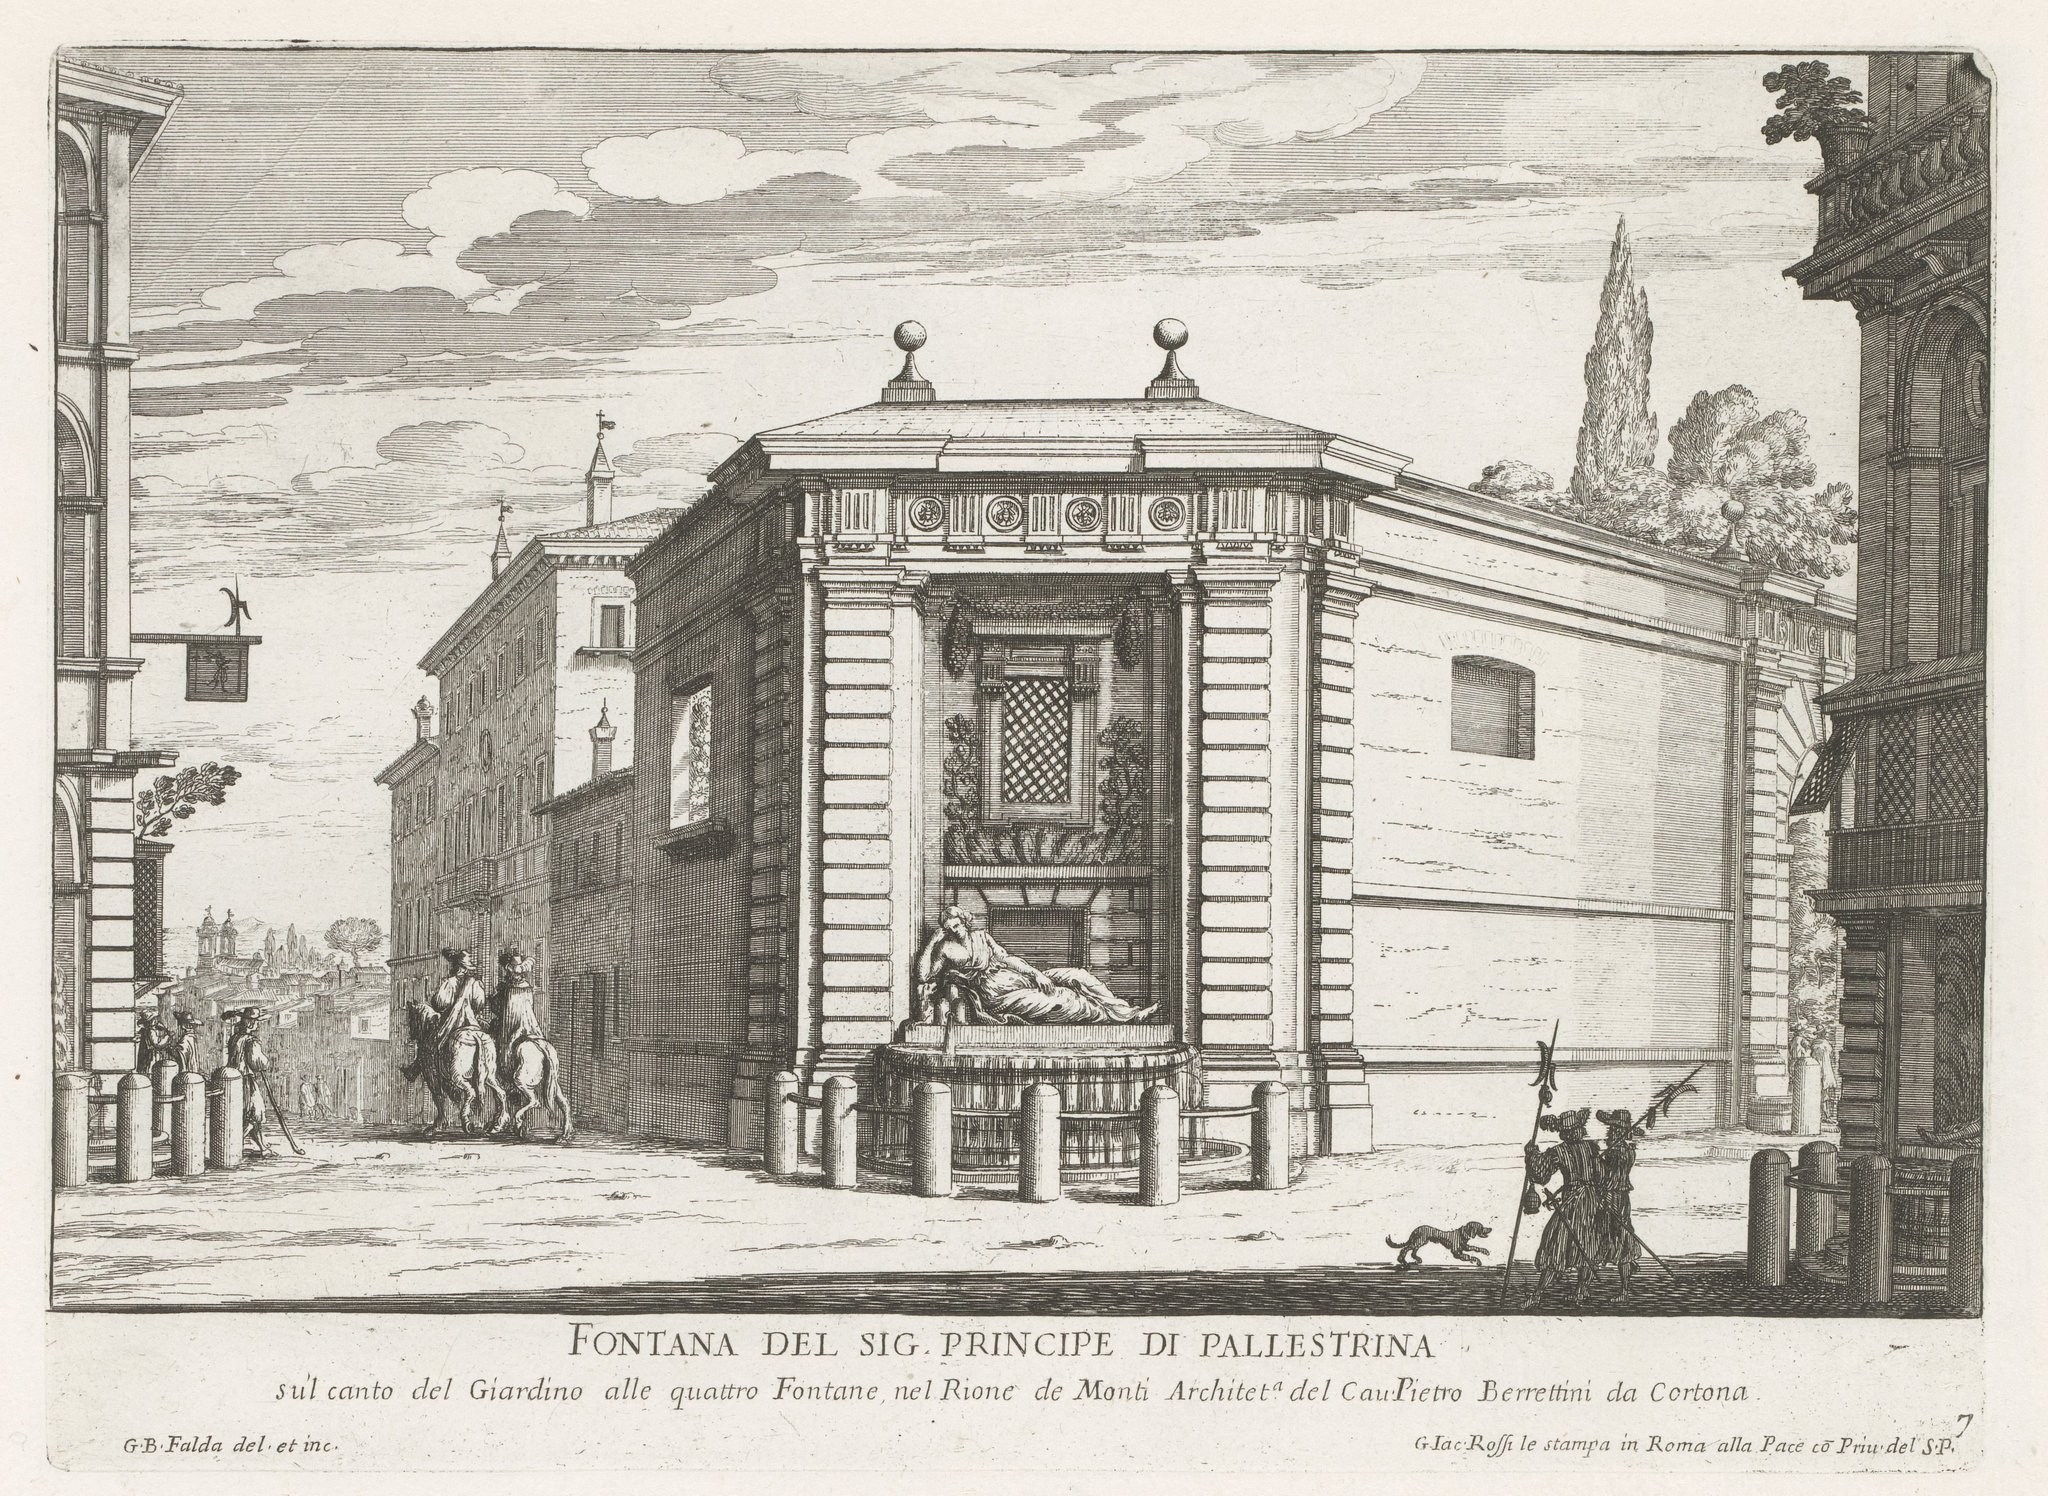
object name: album leaf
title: Dianafontein van de Quattro Fontane te Rome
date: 1653-1691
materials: paper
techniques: etching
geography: vatican city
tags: ornamental fountain, rome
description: Genummerd rechtsonder: 7. De prent maakt deel uit van een album.